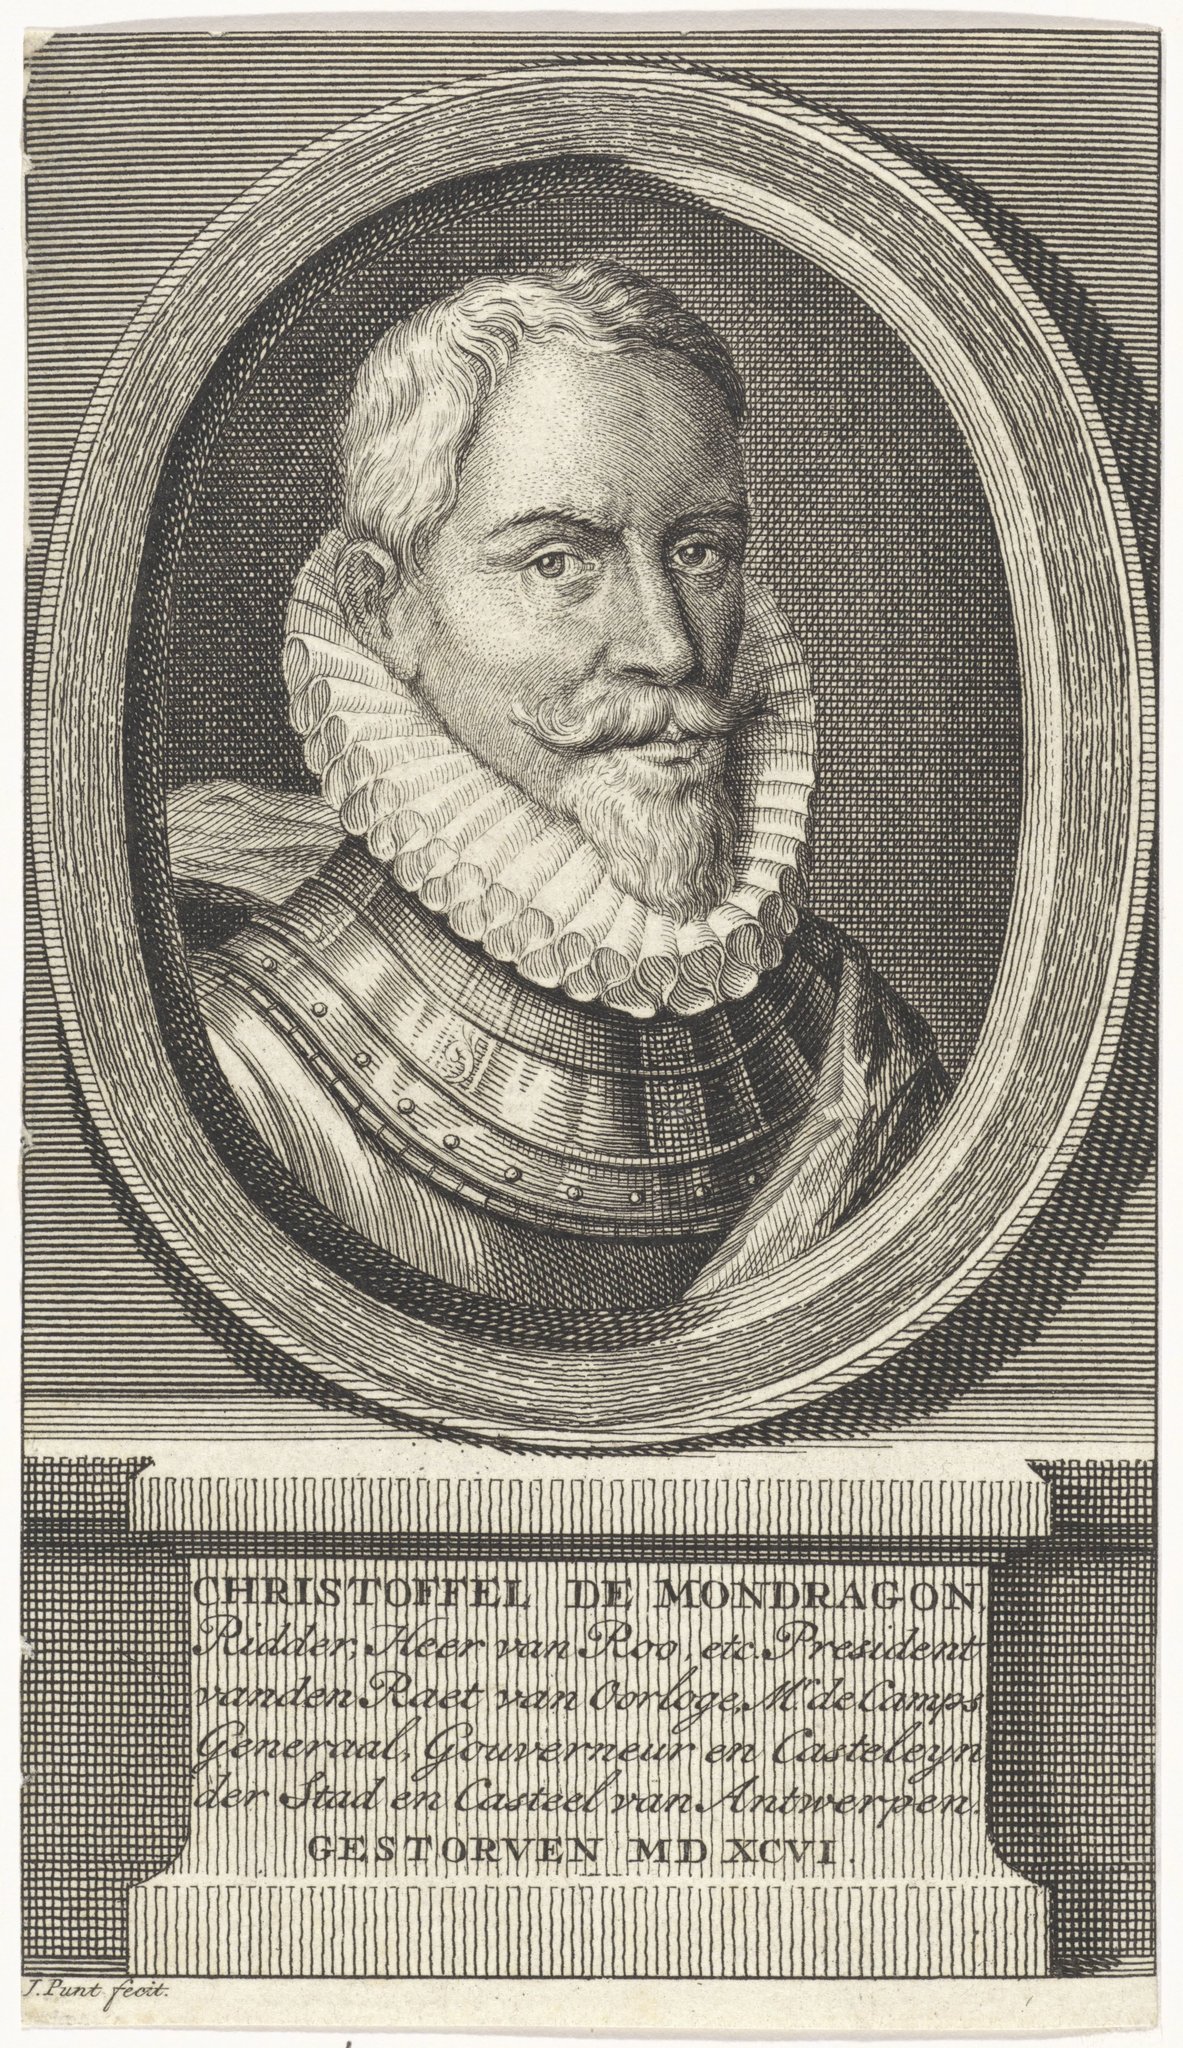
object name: book illustration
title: Portret van Cristóbal de Mondragón y Otalora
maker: jan punt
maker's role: draughtsman, print maker, publisher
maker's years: 1711-1779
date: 1786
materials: paper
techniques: engraving, etching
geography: northern netherlands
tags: antwerp, armour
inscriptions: collector's mark: Lugt 2228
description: Prent gebruikt als illustratie in: Meteren, Emanuel van. Oorlogen en geschiedenissen der Nederlanderen en derzelver nabuuren, deel II, p. 229. Amsterdam: Steven Jacobus Baalde, 1786.